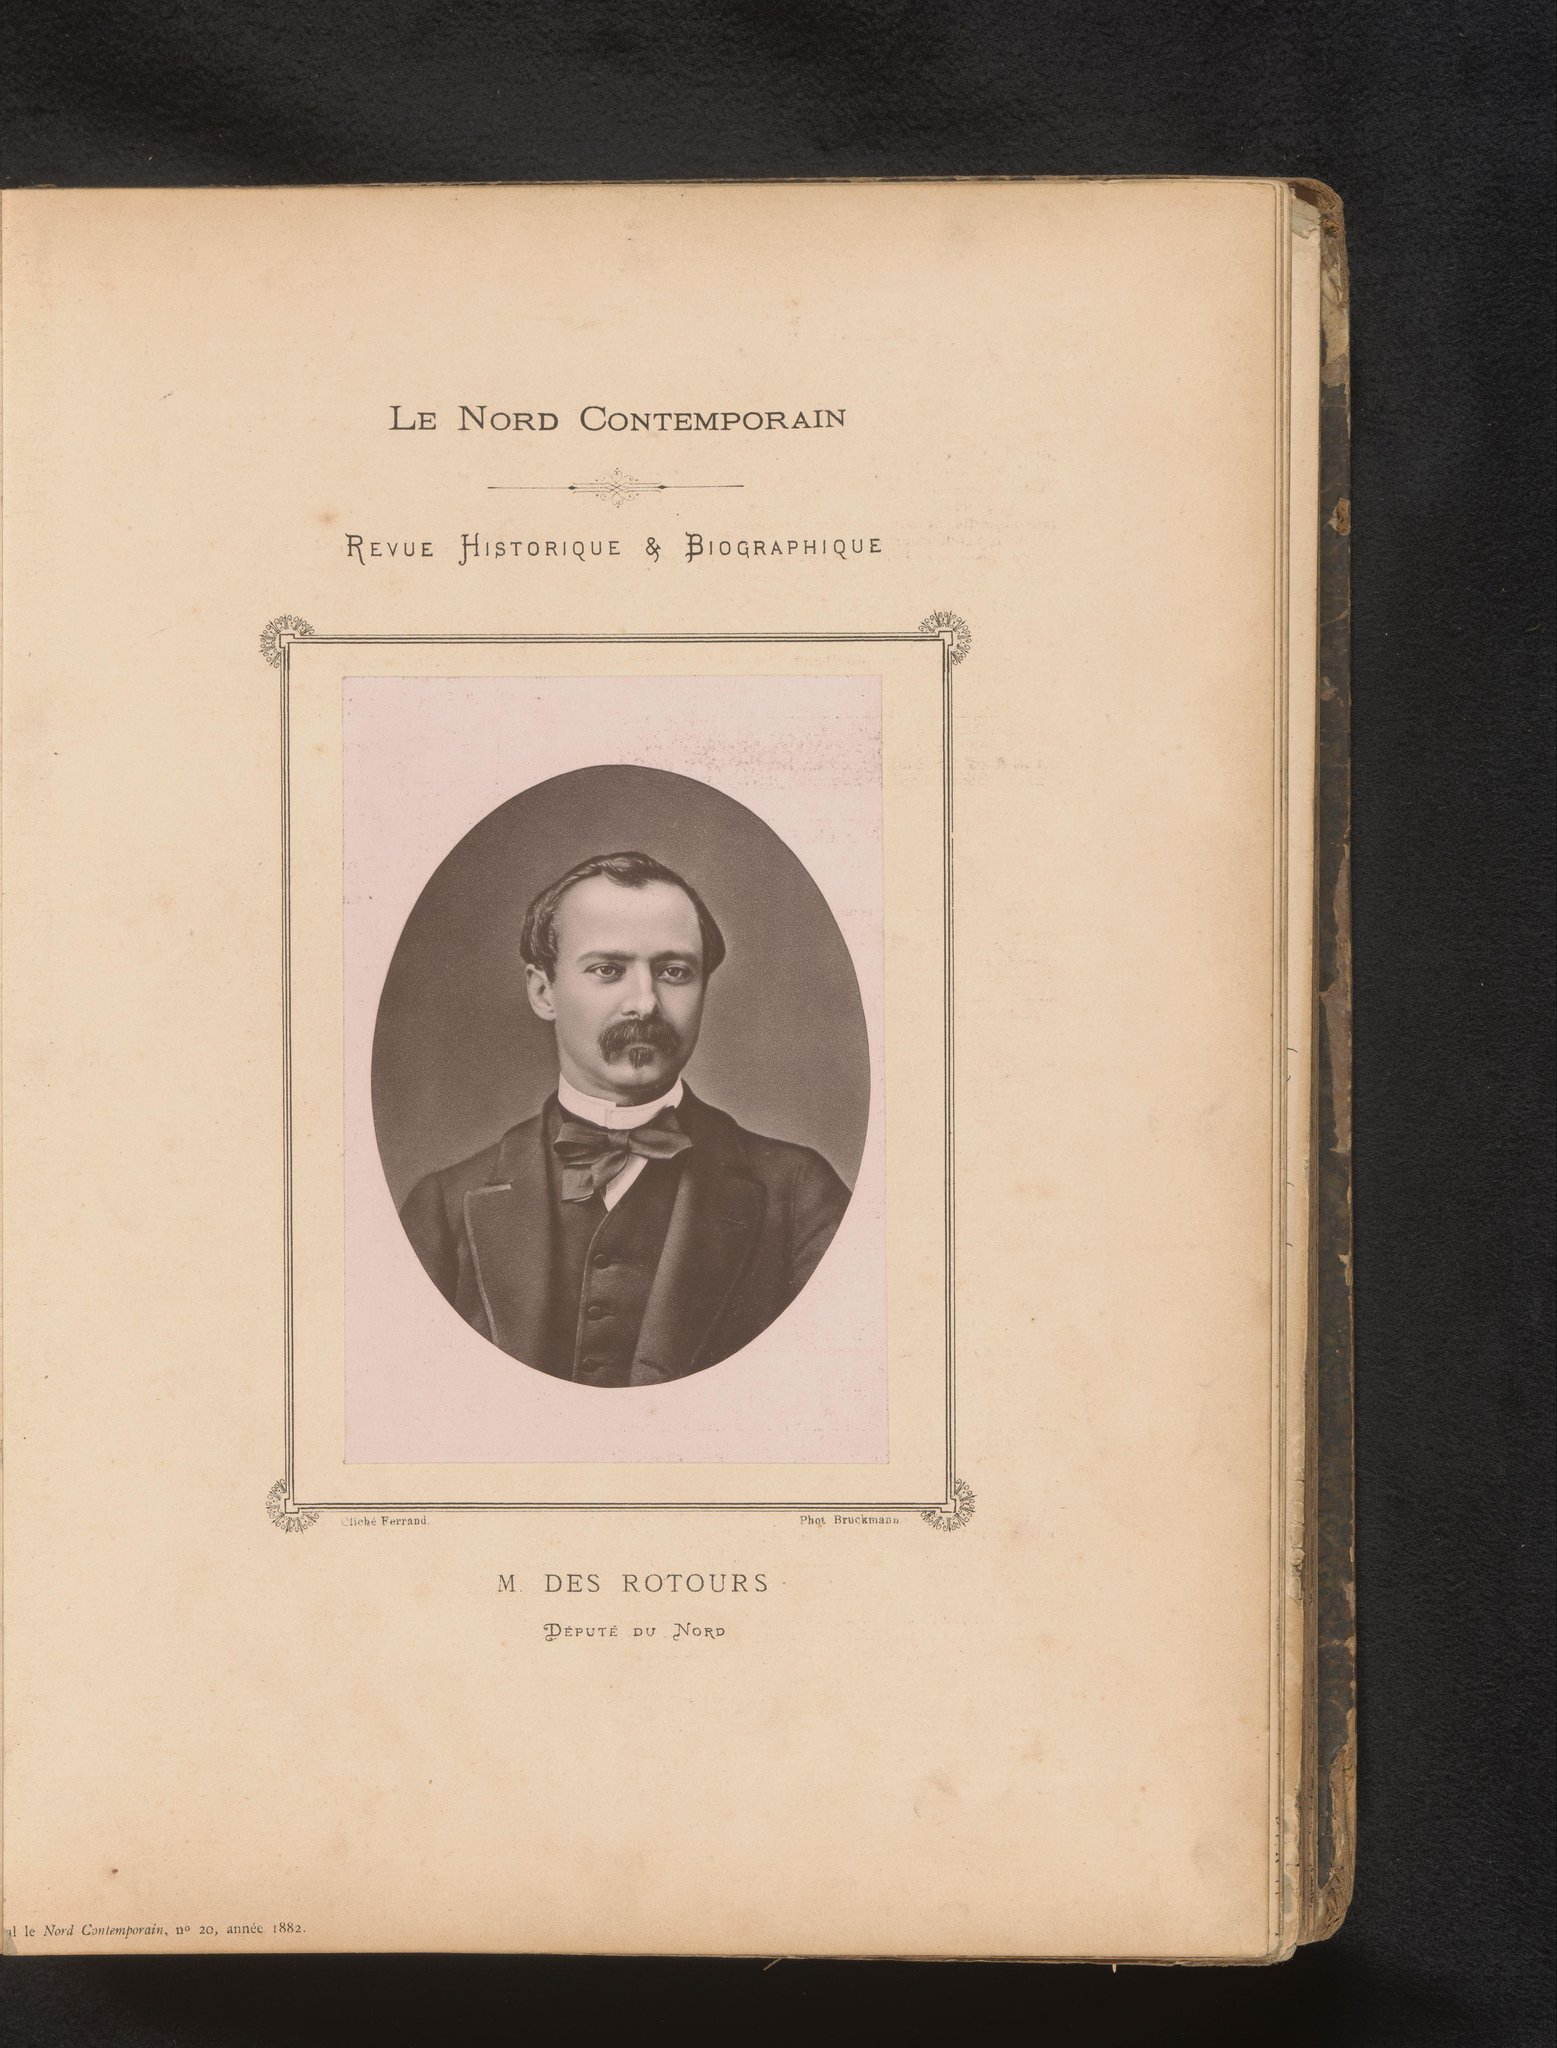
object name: page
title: Portret van Robert Eugène des Rotours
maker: ferrand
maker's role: clichémaker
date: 1877-1882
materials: paper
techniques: photograph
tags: historical persons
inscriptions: inscription: ‘[Journ]al le Nord Contemporain, No 20, année 1882.’, inscription: ‘Le Nord Contemporain/ Revue Historique & Biographique’